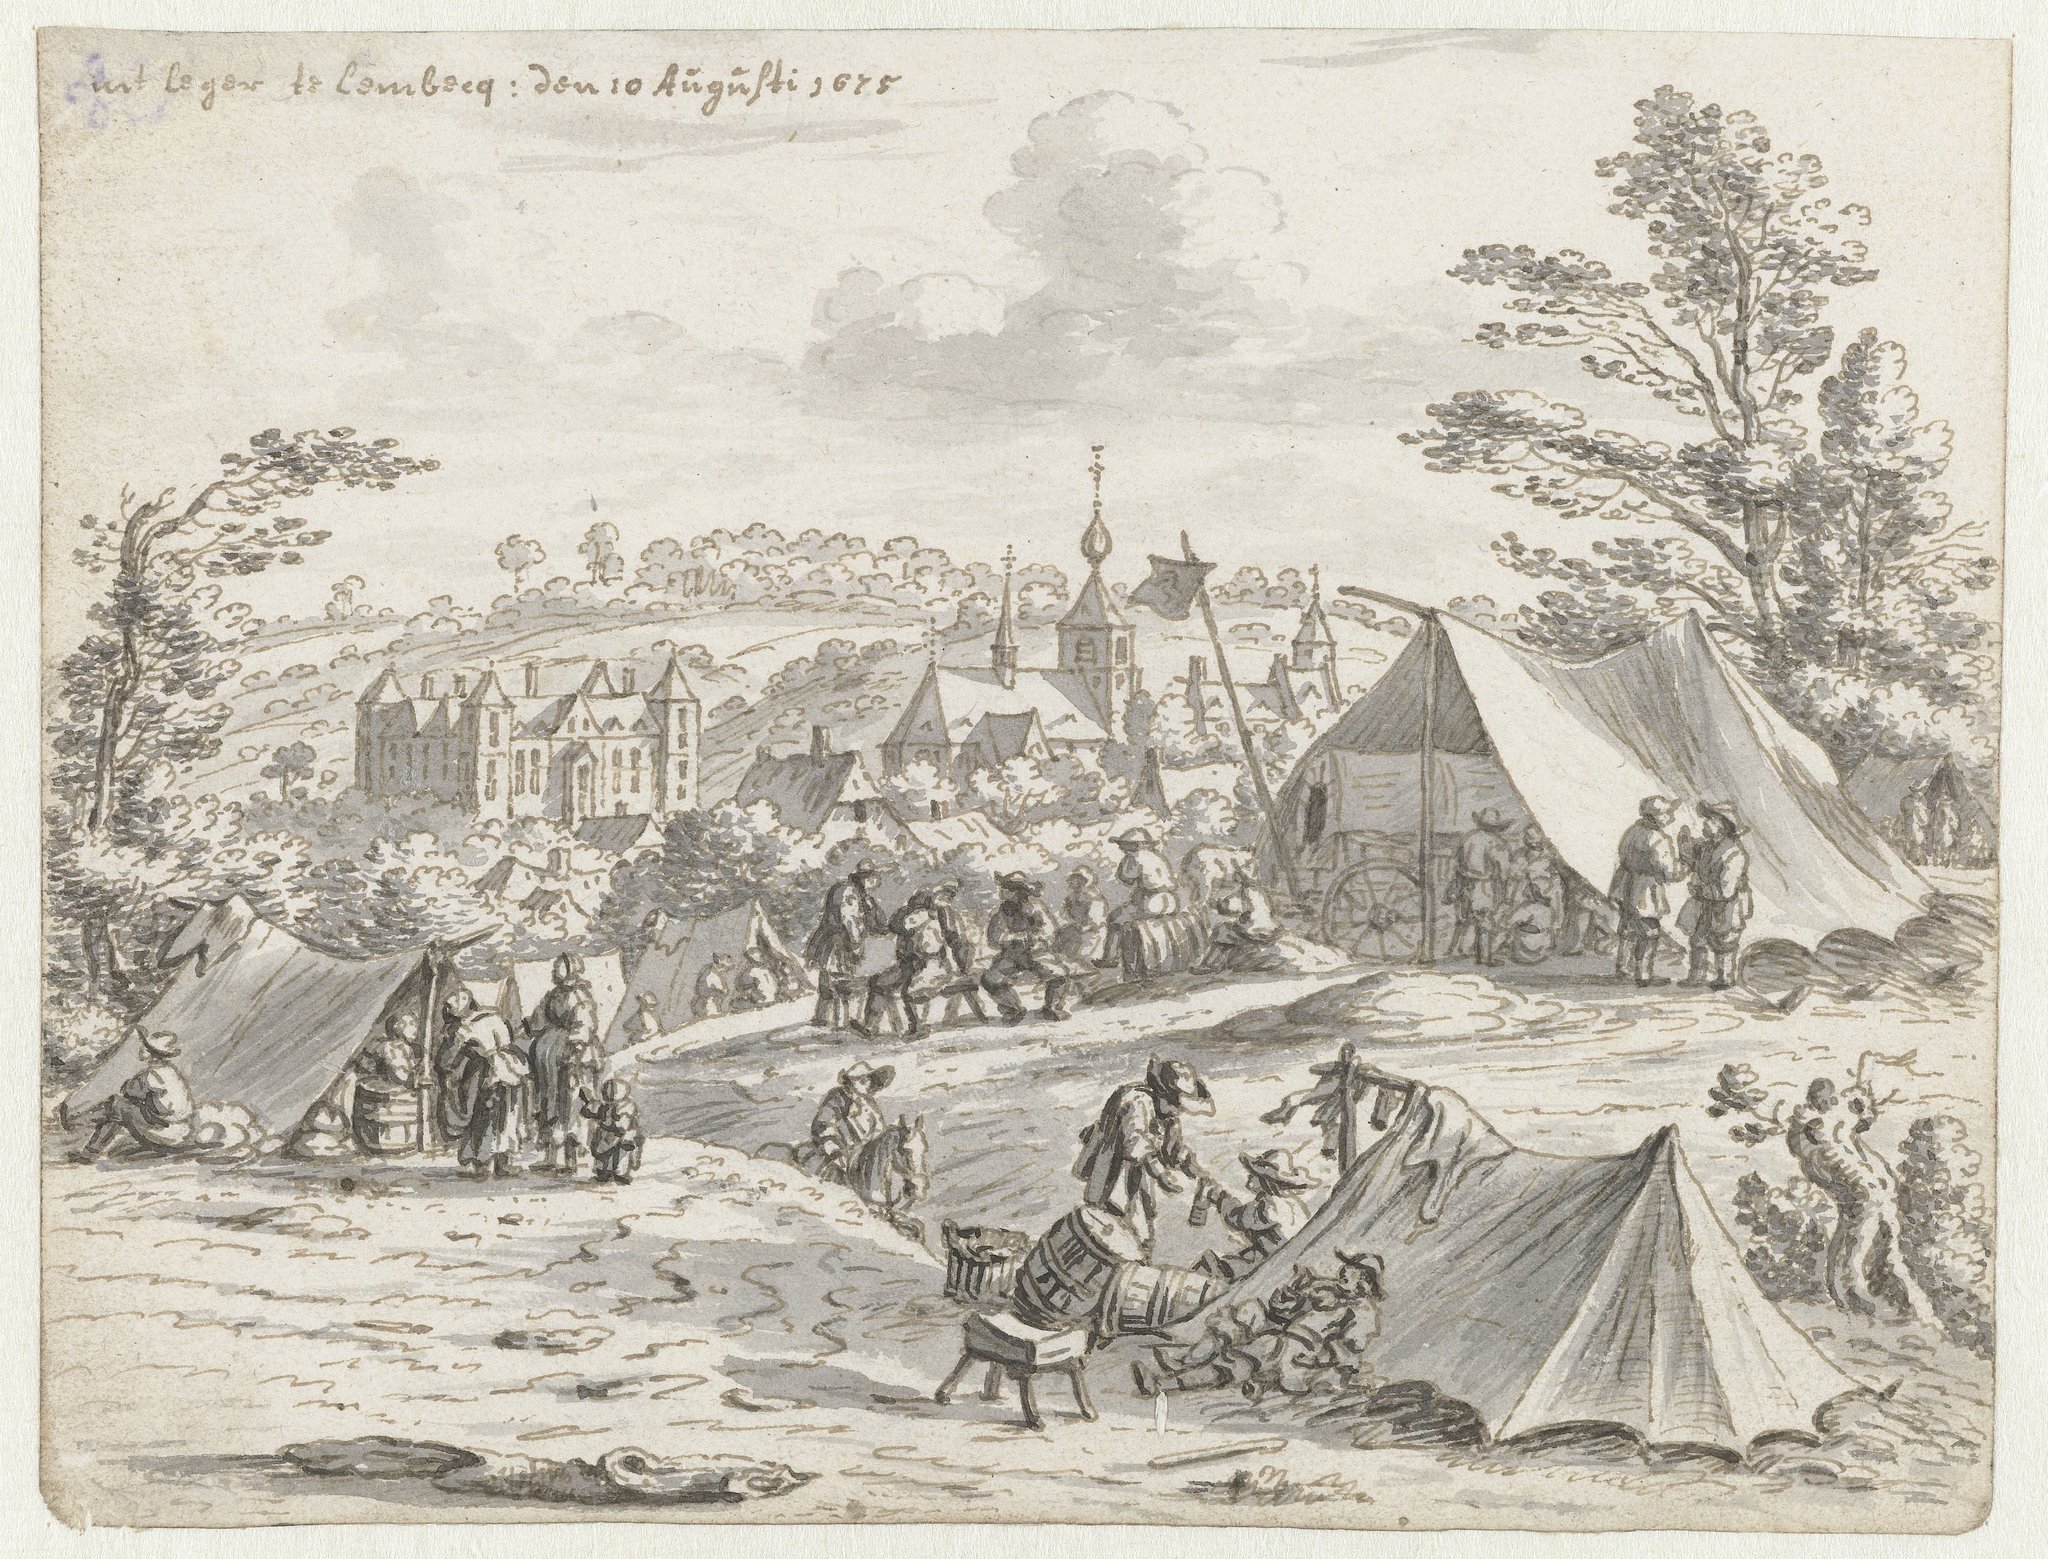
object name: drawing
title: View of an Encampment of the Army of Willem III at Lembeek, Hainaut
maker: josua de grave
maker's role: draughtsman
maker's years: 1645-1712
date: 1675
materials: ink, paper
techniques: brush, pen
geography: lembeek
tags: the hague, william iii (prince of orange and king of england, scotland, and ireland), (military) camp with tents, lembeek